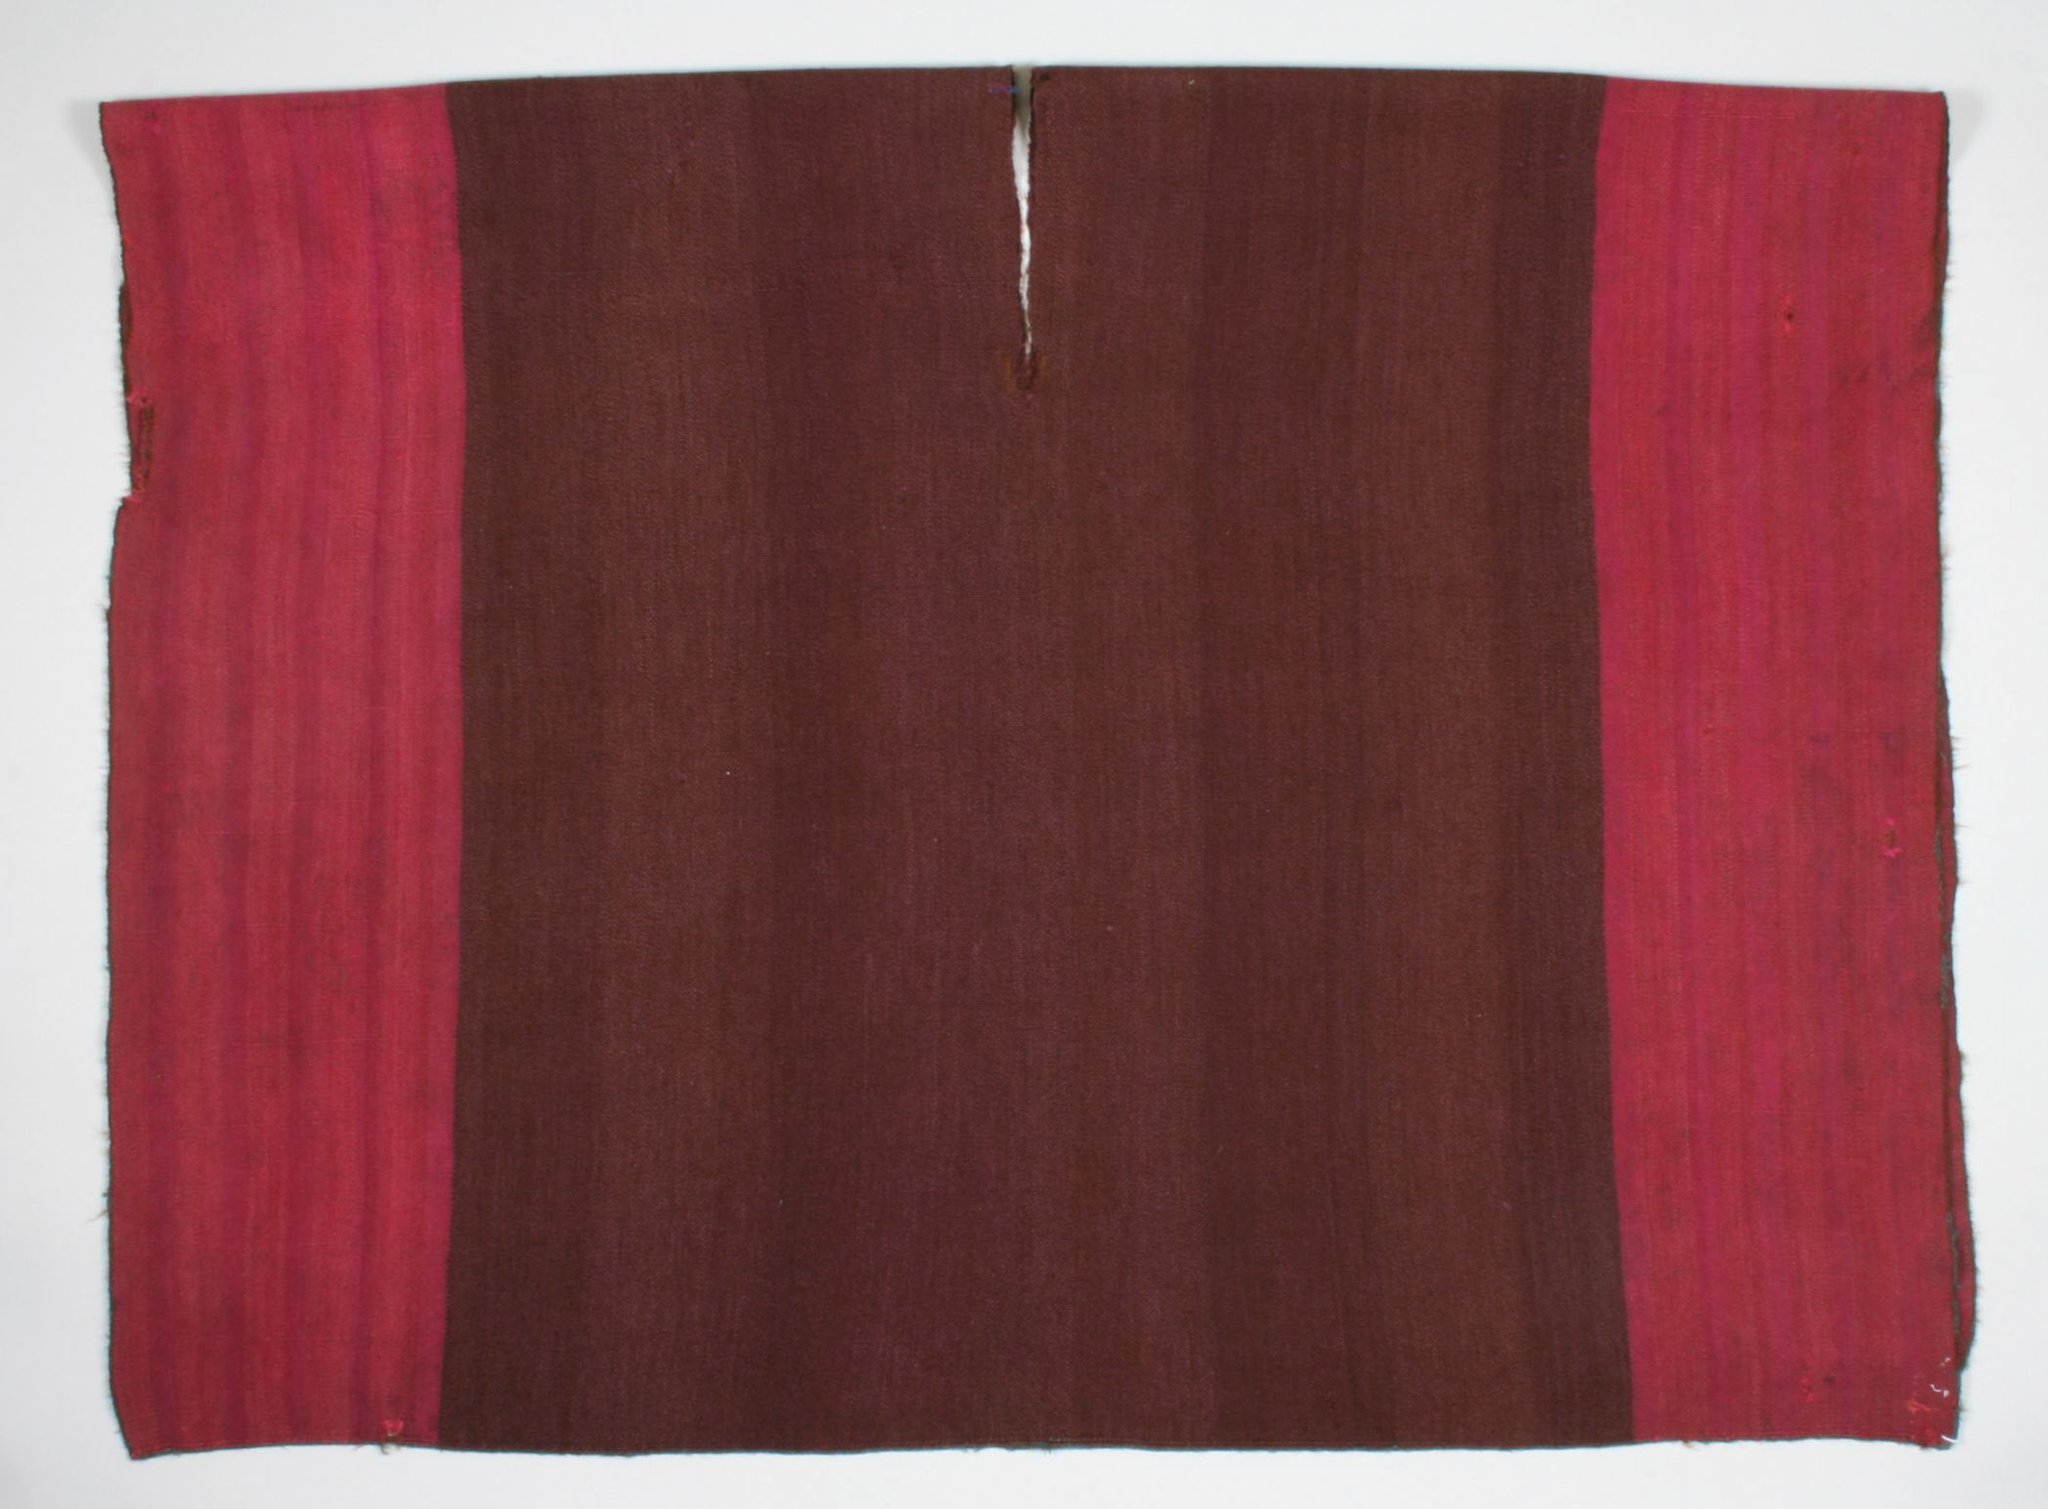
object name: tunic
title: Man's Tunic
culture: aymara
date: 1601-1800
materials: animal fiber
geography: bolivia